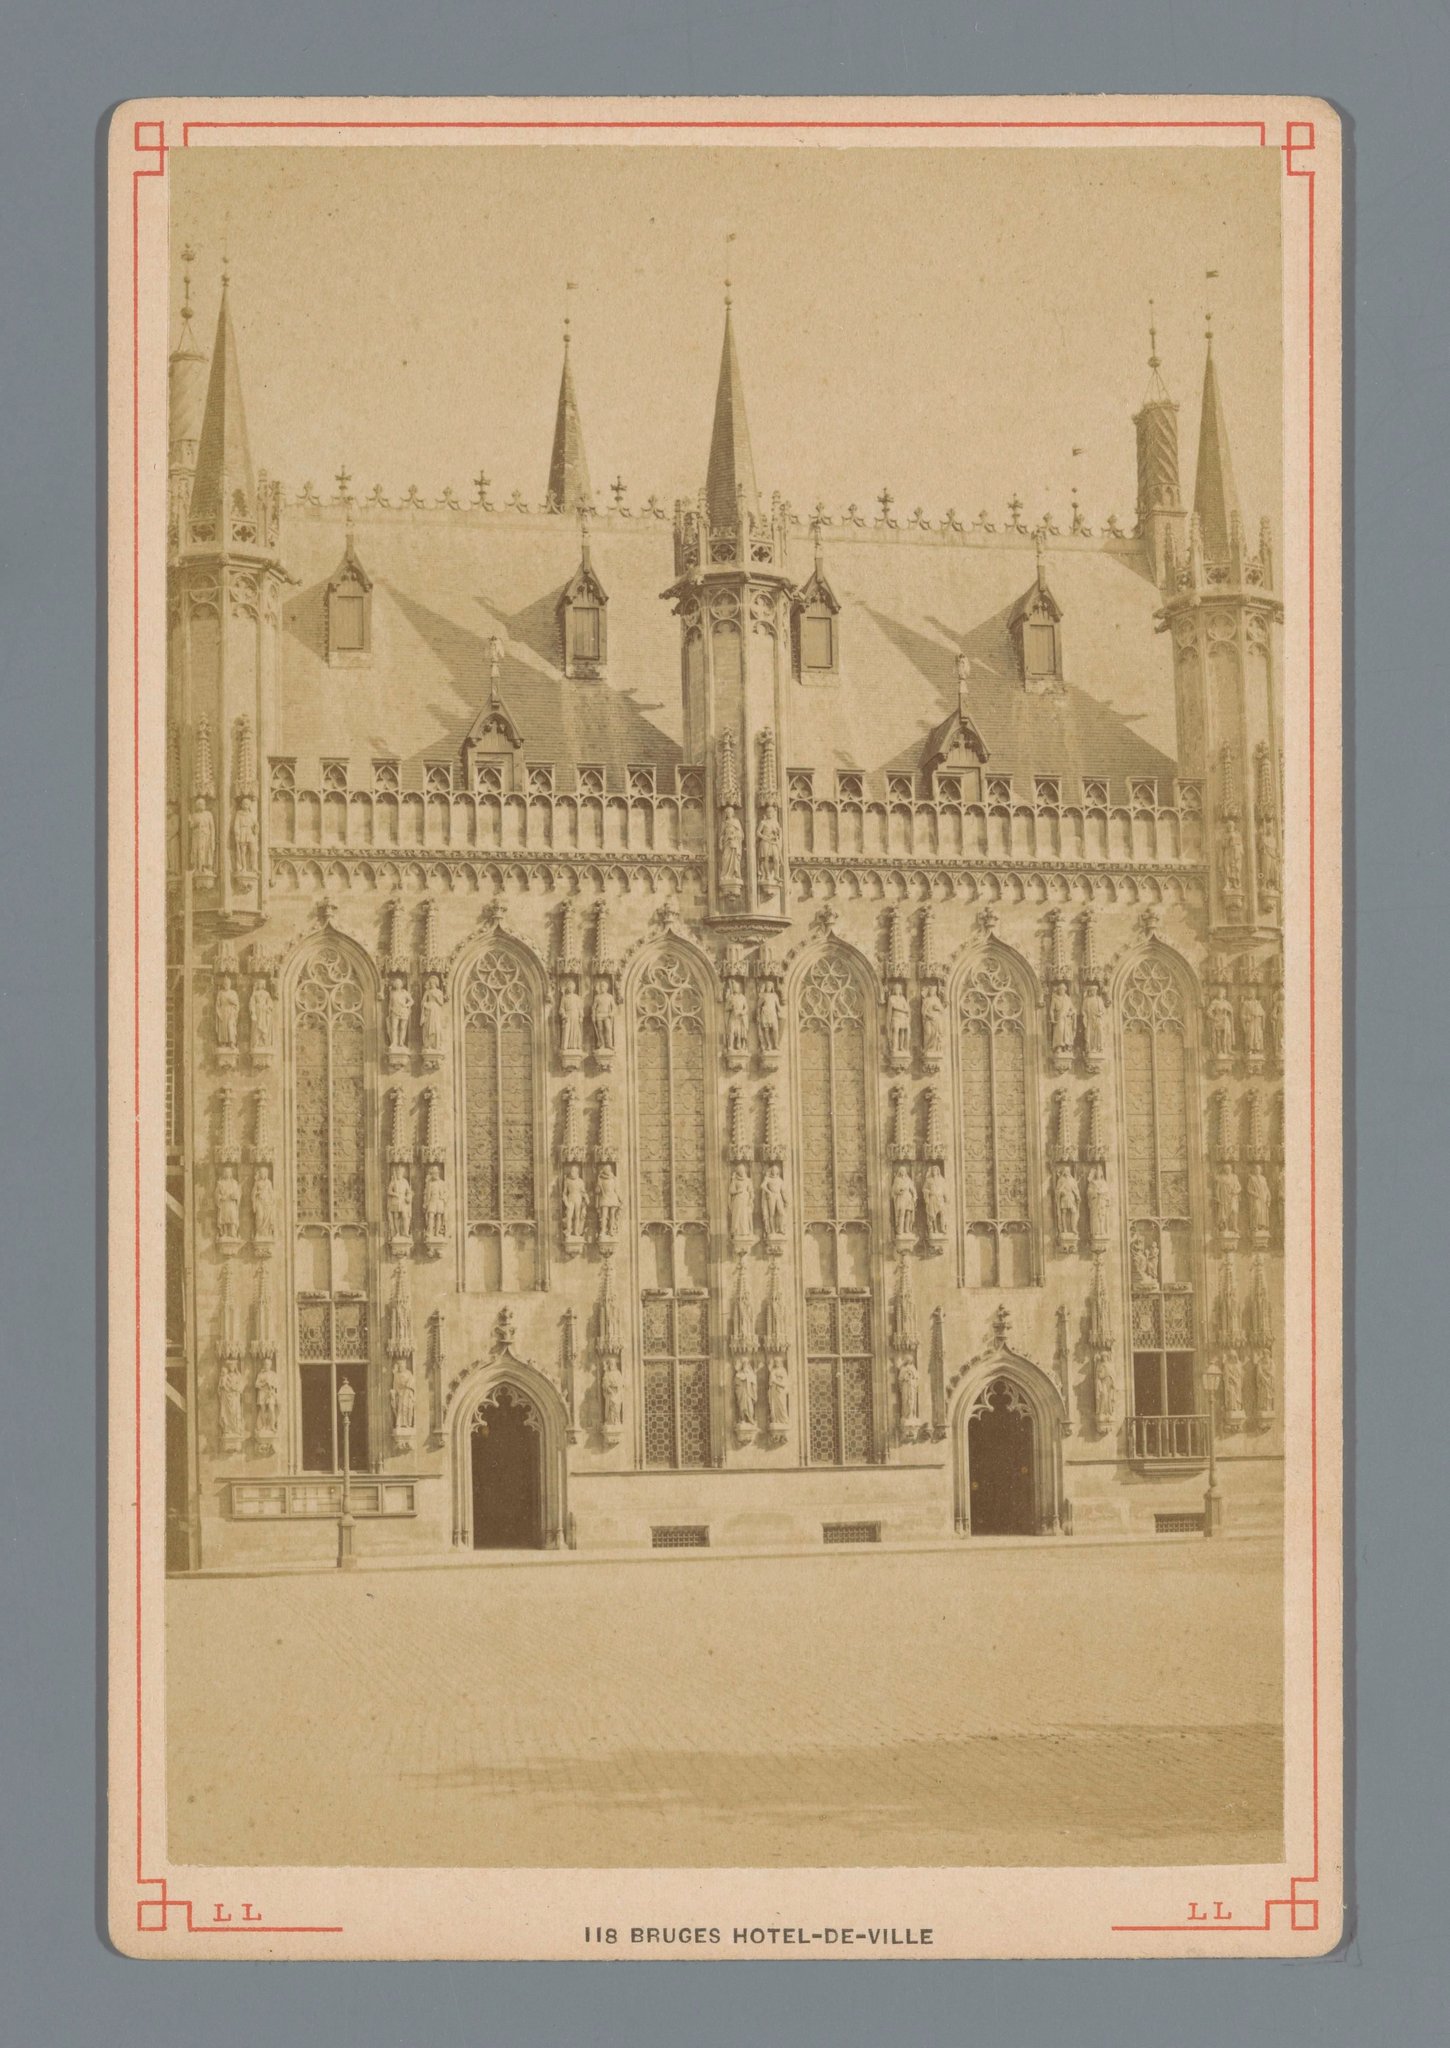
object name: cabinet photograph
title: Bruges Hotel-de-Ville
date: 1864-1900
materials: cardboard, photographic support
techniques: albumen print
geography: brugge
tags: townhall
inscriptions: number: ‘118’